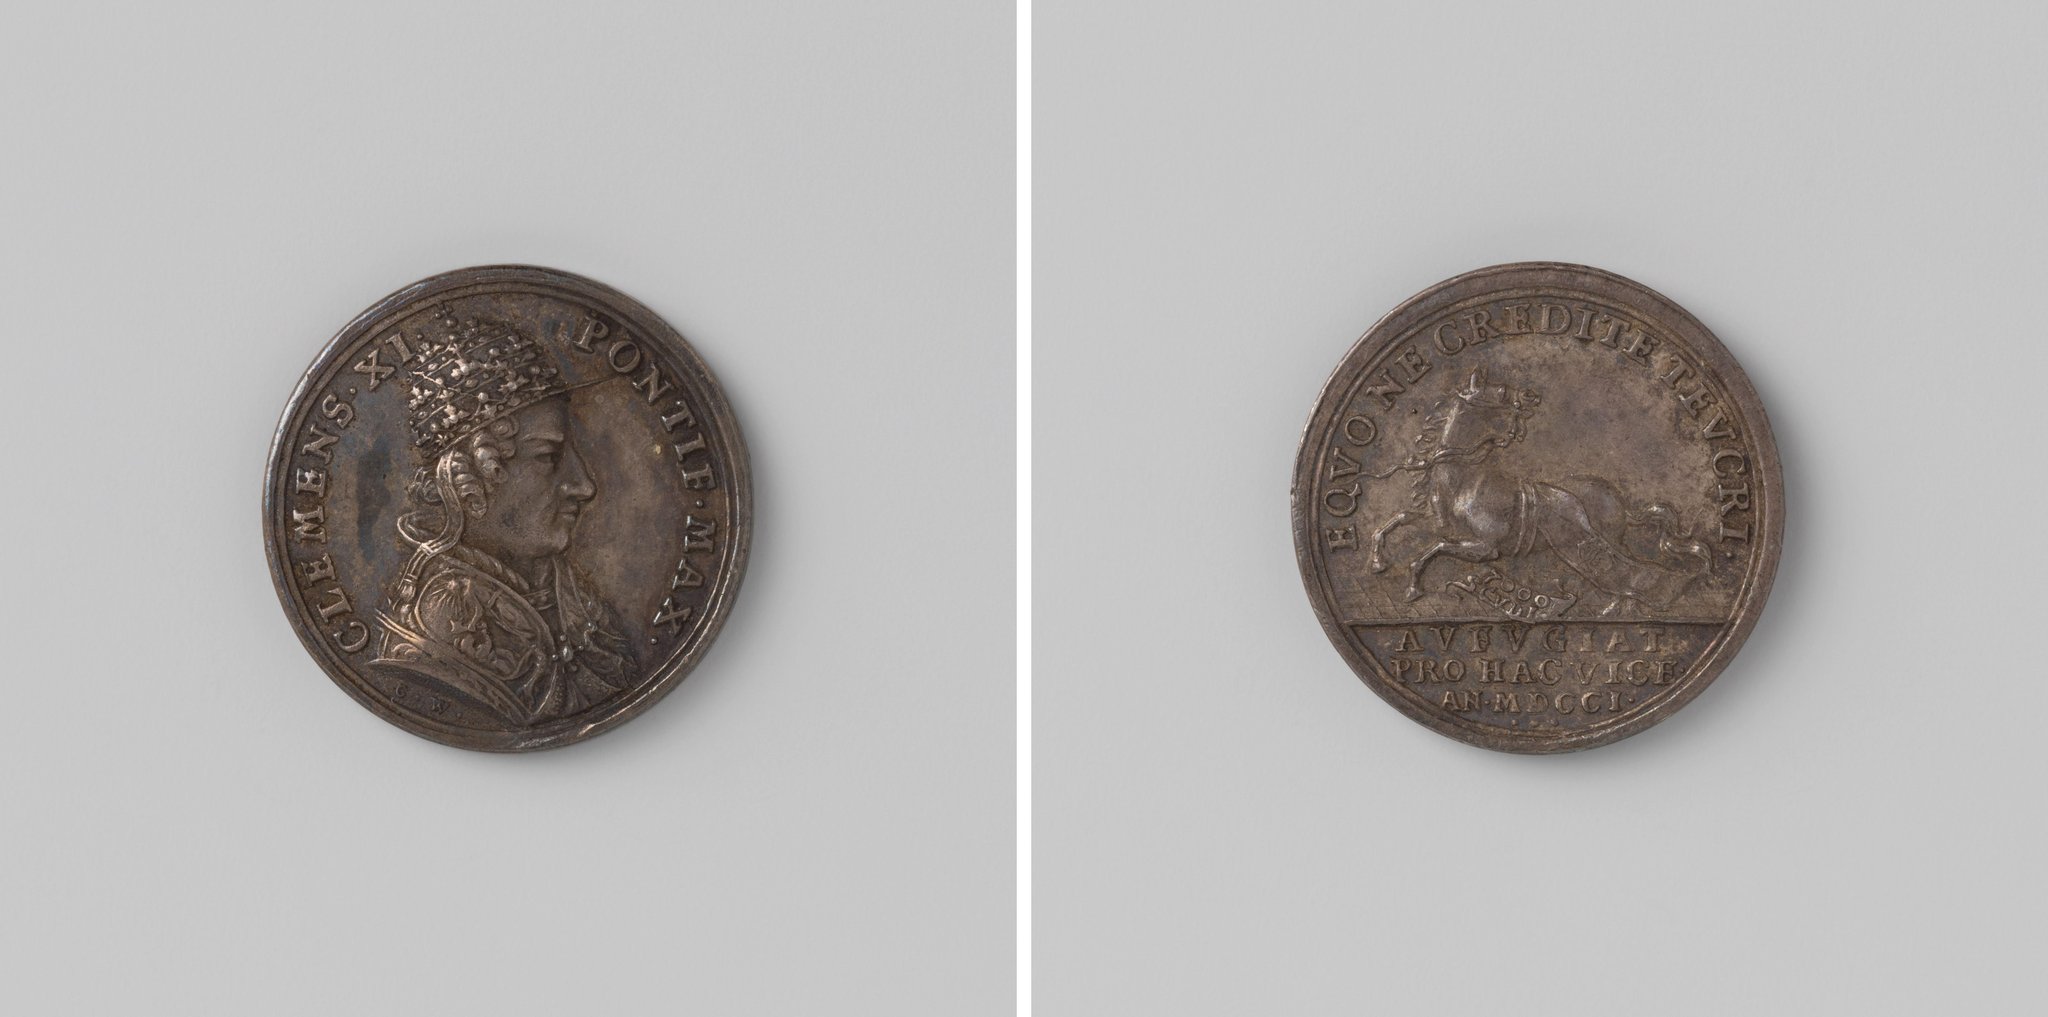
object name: history medal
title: Clemens XI, onenigheid over het koninkrijk Napels en Sicilie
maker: christian wermuth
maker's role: medailleur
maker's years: 1661-1739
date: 1701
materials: silver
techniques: striking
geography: gotha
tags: clergyman, clemens xi, italy, naples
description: Zilveren penning. Voorzijde: borststuk man met tiara binnen omschrift. Keerzijde: galopperend paard dat zijn dekkleed afwerpt binnen omschrift, boven opschrift.